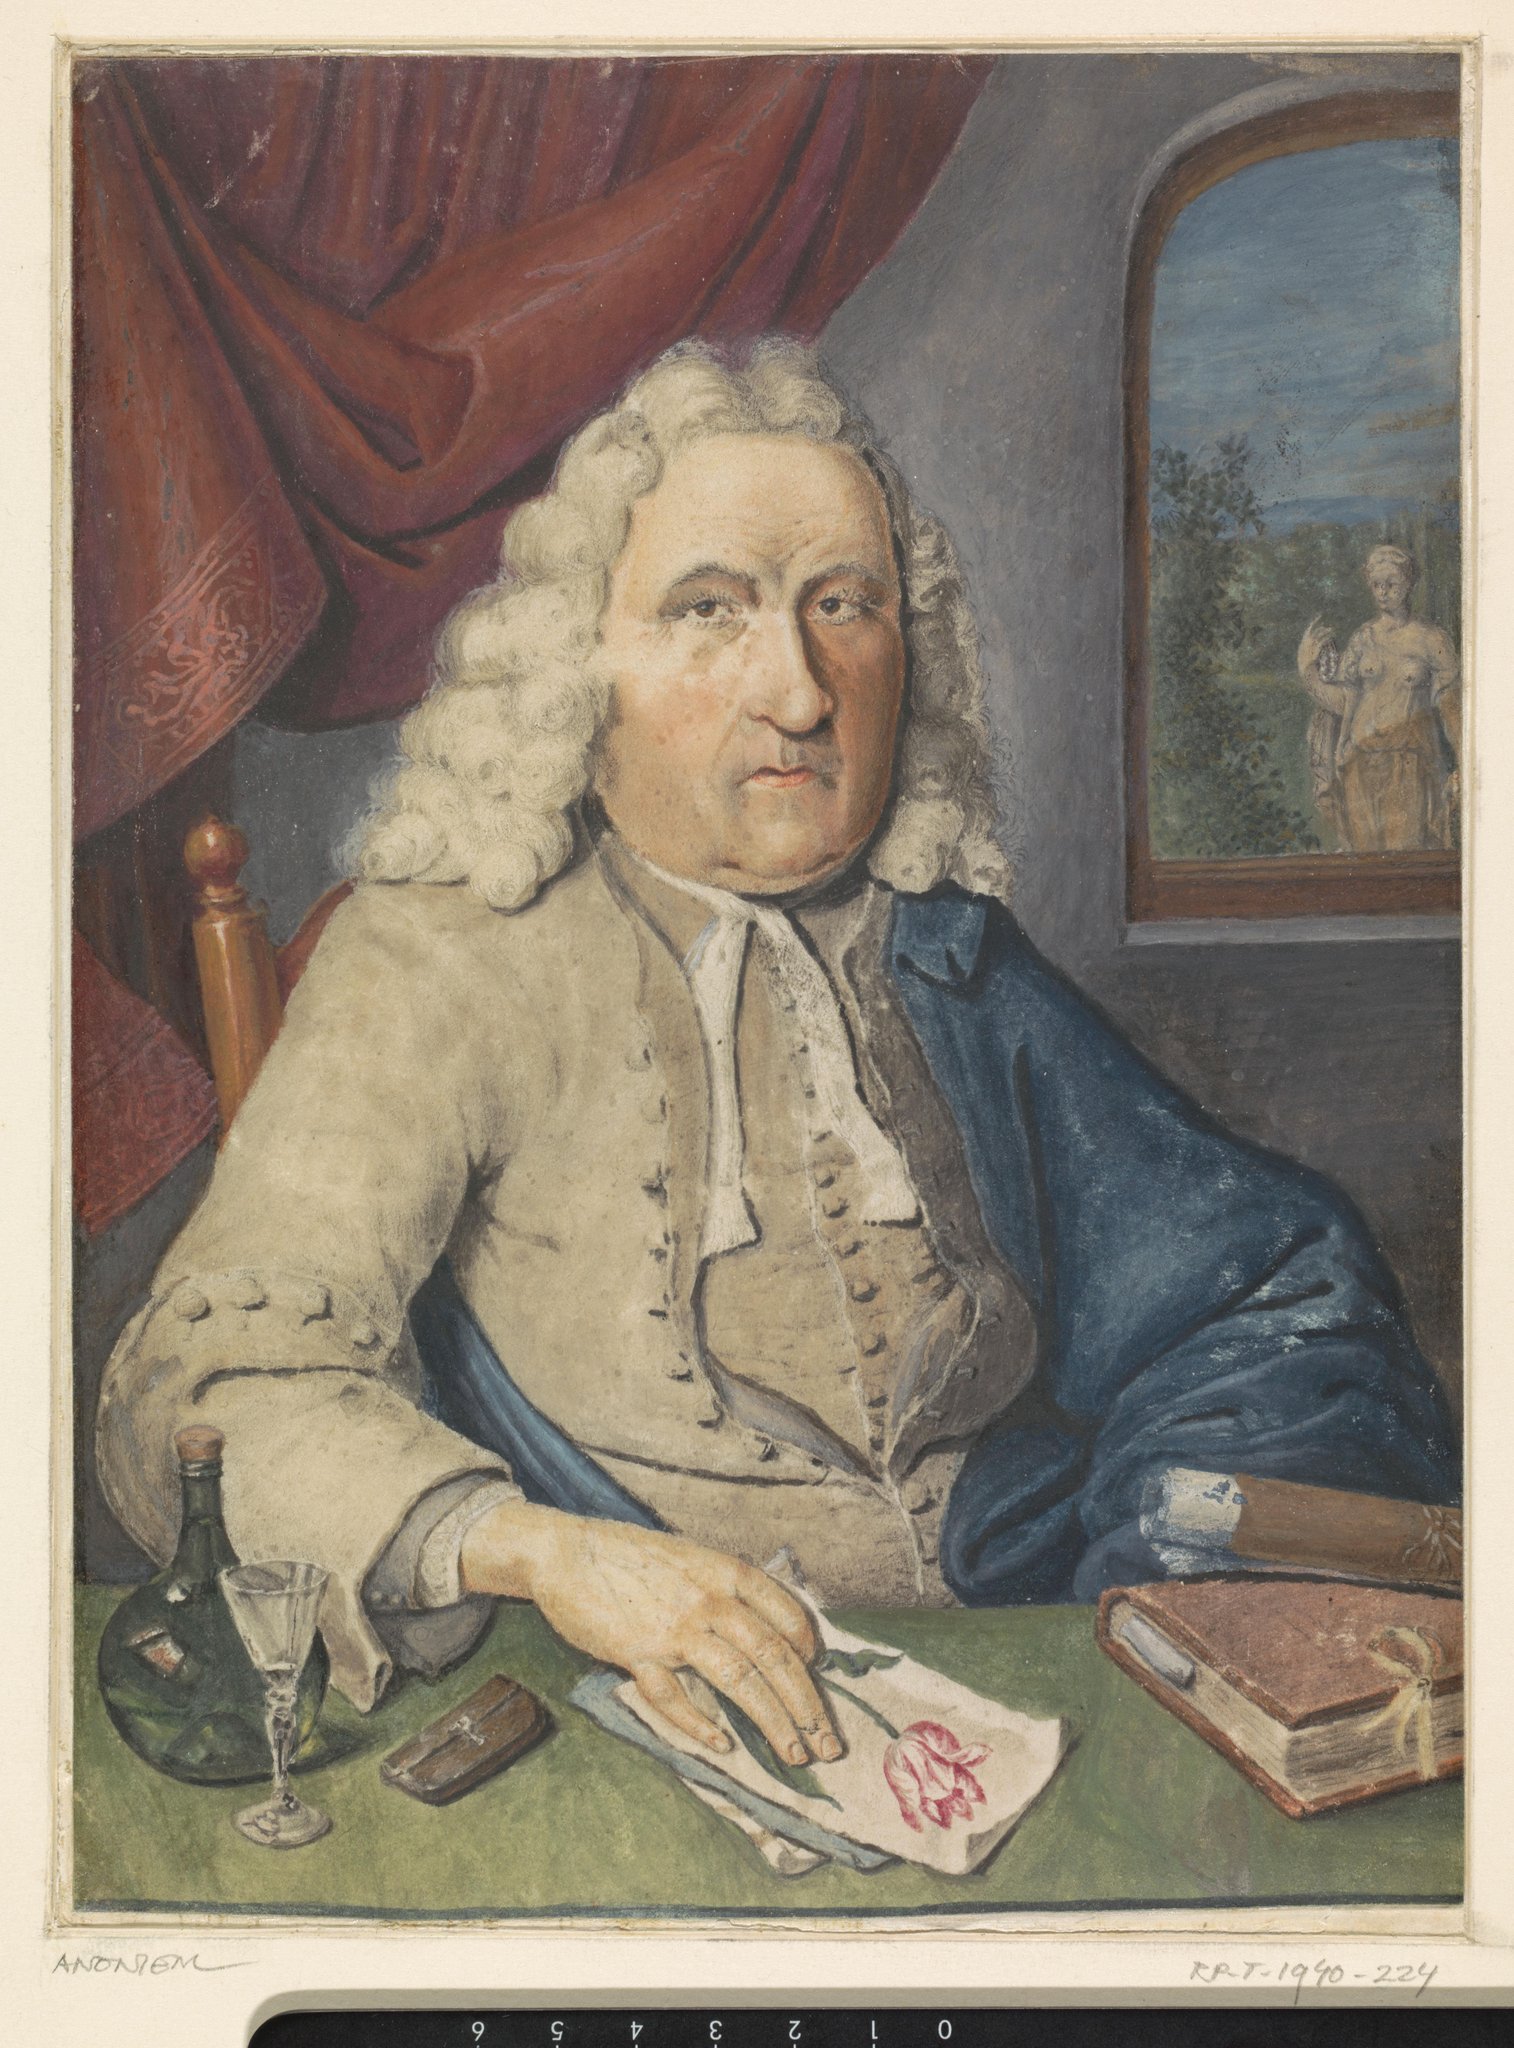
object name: drawing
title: Portret van Johannes Hendrik Knoop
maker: Anonymous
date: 1779-1883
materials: parchment, watercolor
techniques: brush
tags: amsterdam, painter, johannes hendrik knoop, historical persons, portrait, self-portrait of artist